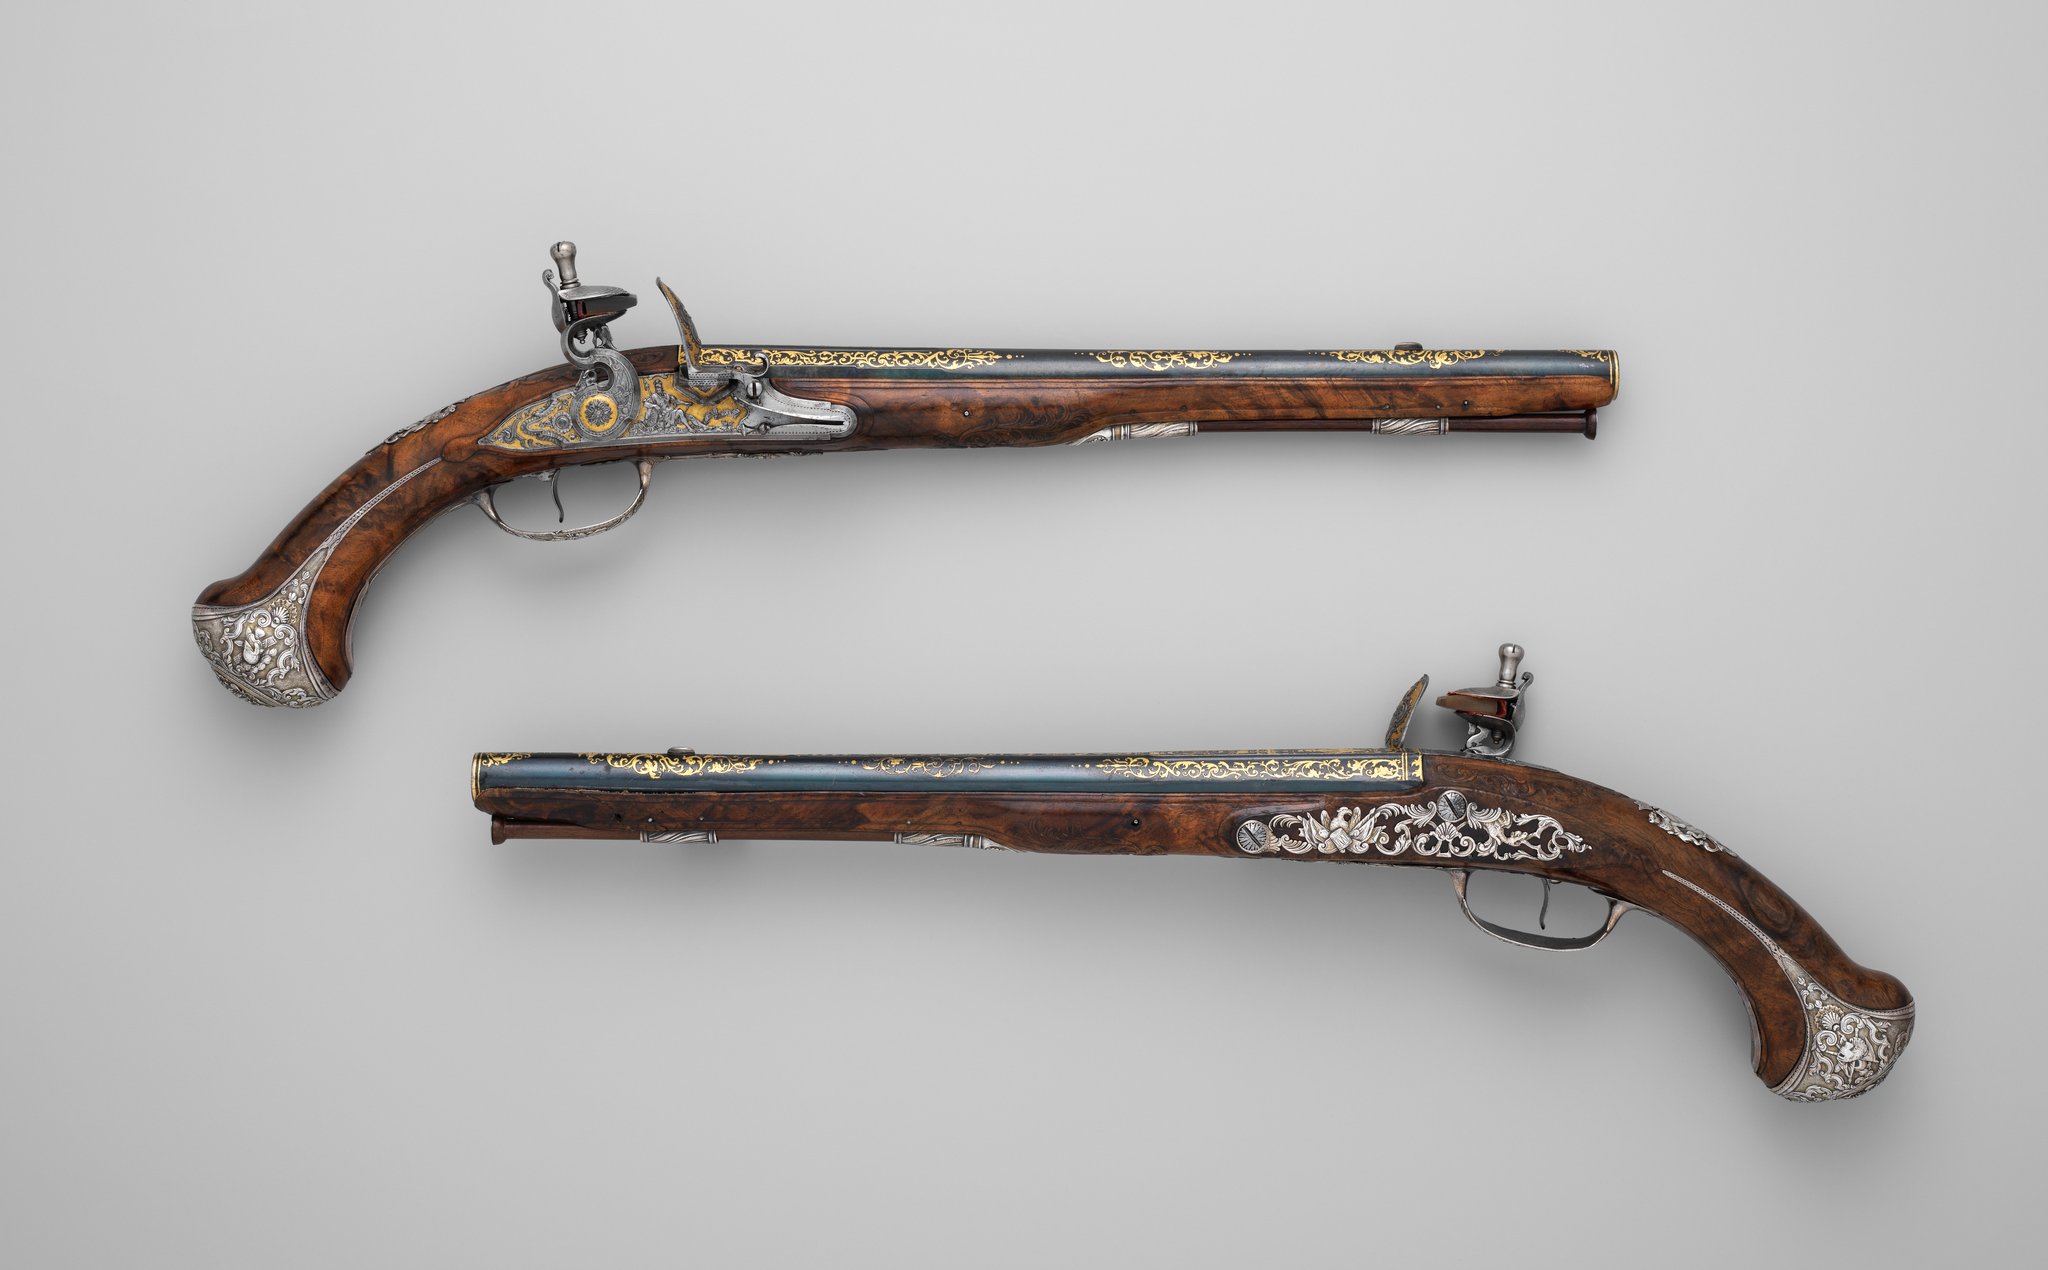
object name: pair of flintlock pistol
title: Pair of Flintlock Pistols of Count Heinrich von Brühl (1700–1763)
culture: french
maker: adrien reynier the younger, called le hollandois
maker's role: gunsmith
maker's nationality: french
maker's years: 1680-1743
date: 1740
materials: copper alloy, gold, silver, steel, wood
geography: france